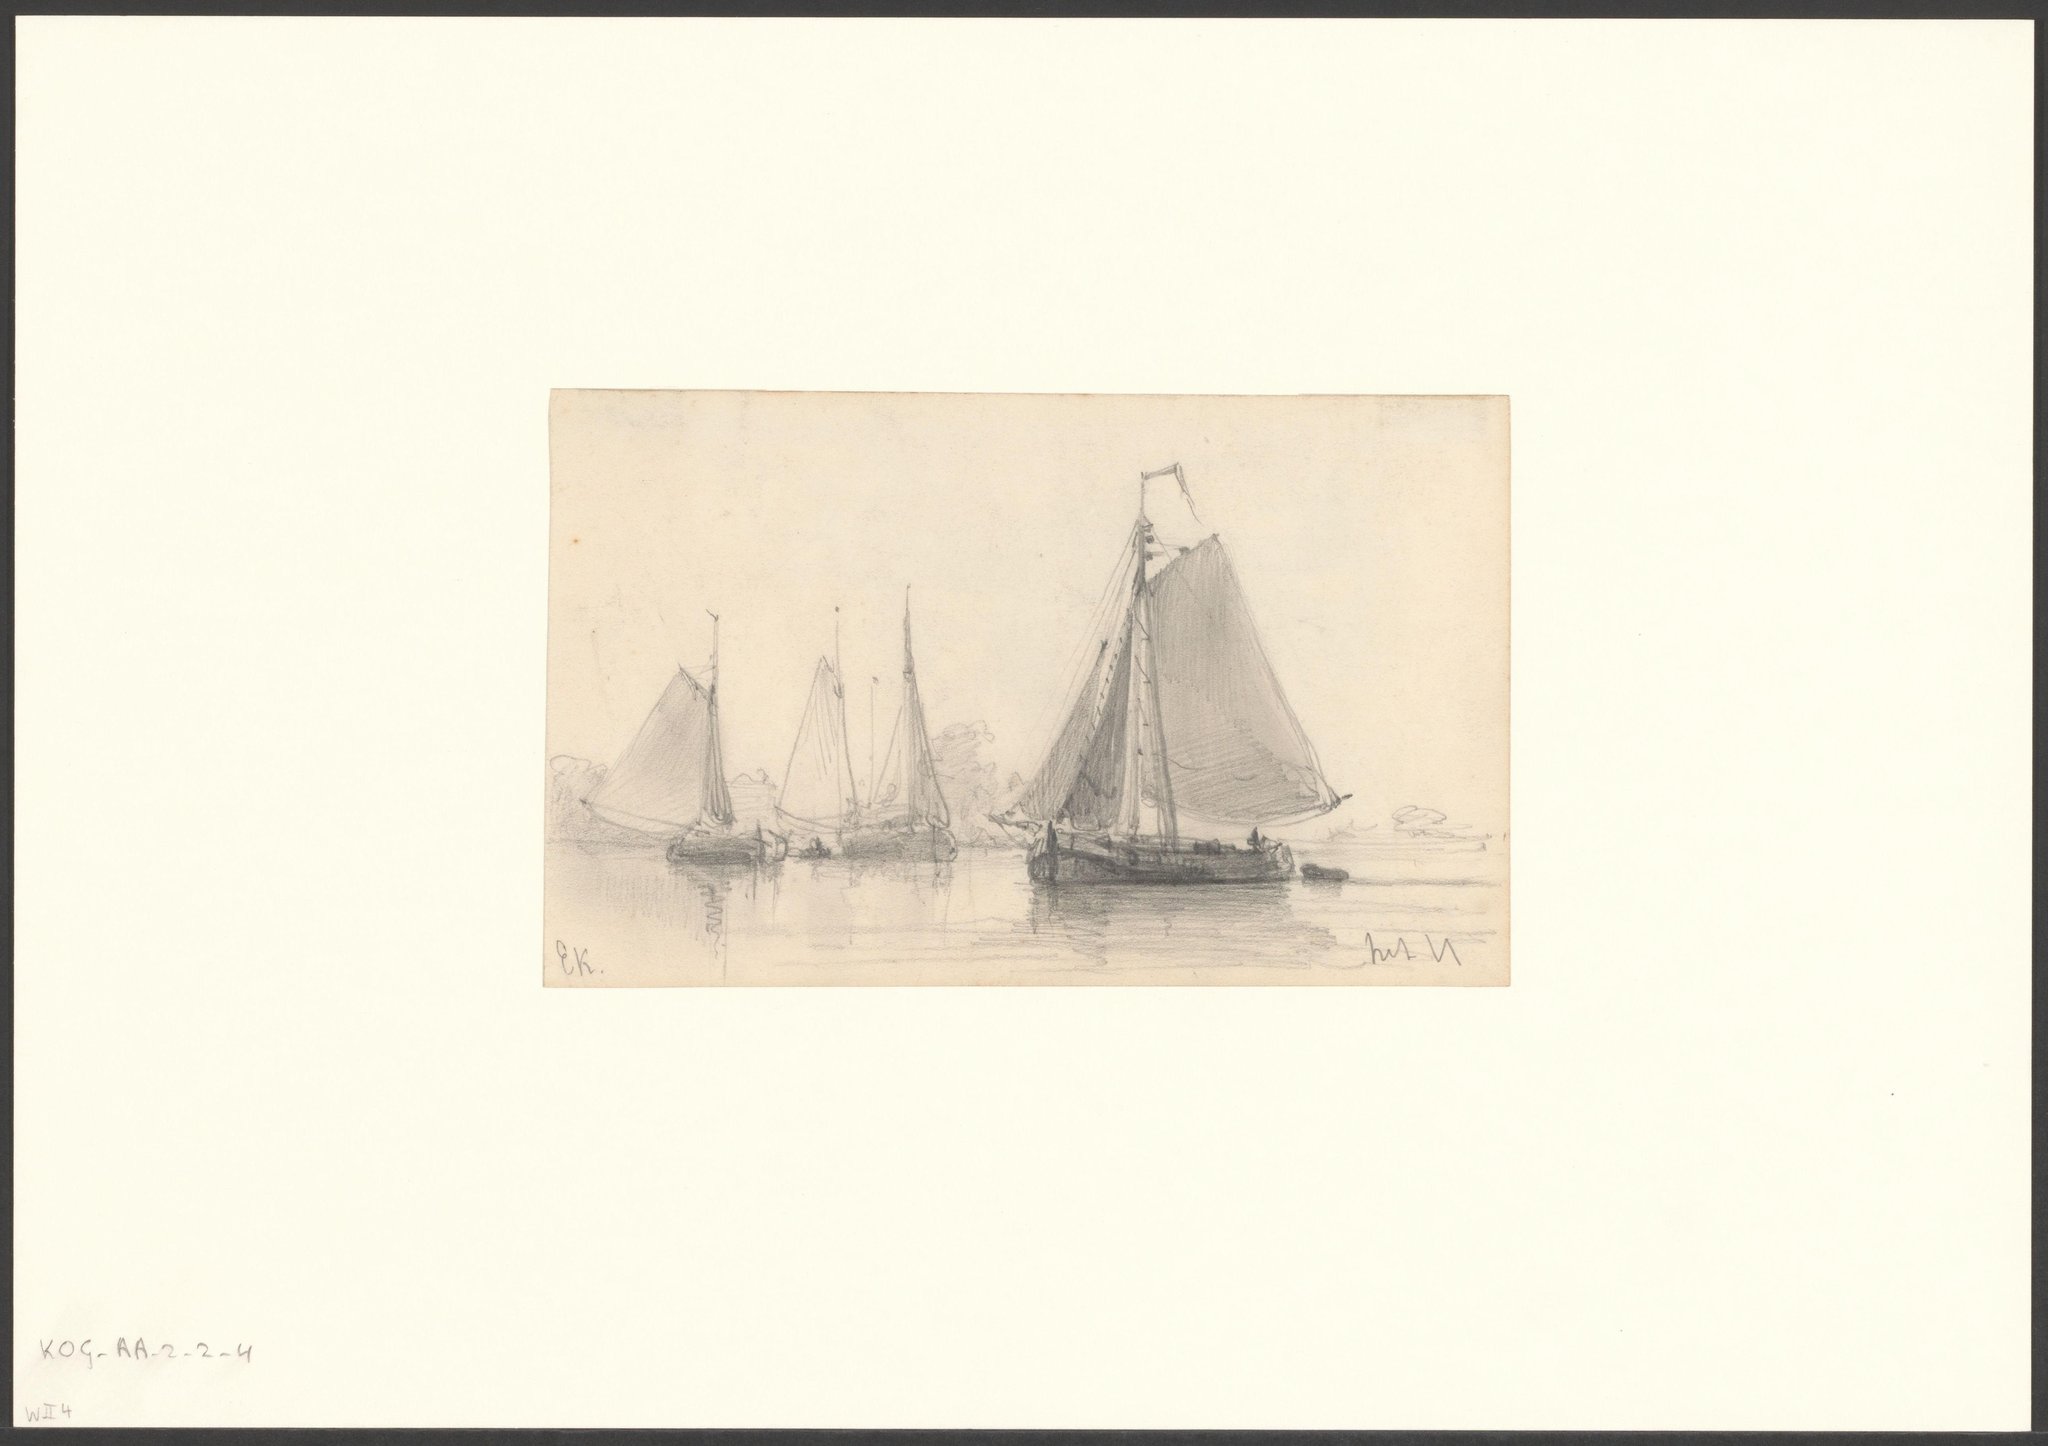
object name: drawing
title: Gezicht op zeilschepen op het IJ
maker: everhardus koster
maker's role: draughtsman, painter, print maker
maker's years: 1817-1892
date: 1827-1892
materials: paper, pencil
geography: amsterdam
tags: sailing-ship, sailing-boat, river, amsterdam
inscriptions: initials: ‘EK.’, inscription: ‘het IJ’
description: Tekening binnen de Atlas Van Eck ingedeeld op wijknummer 2.